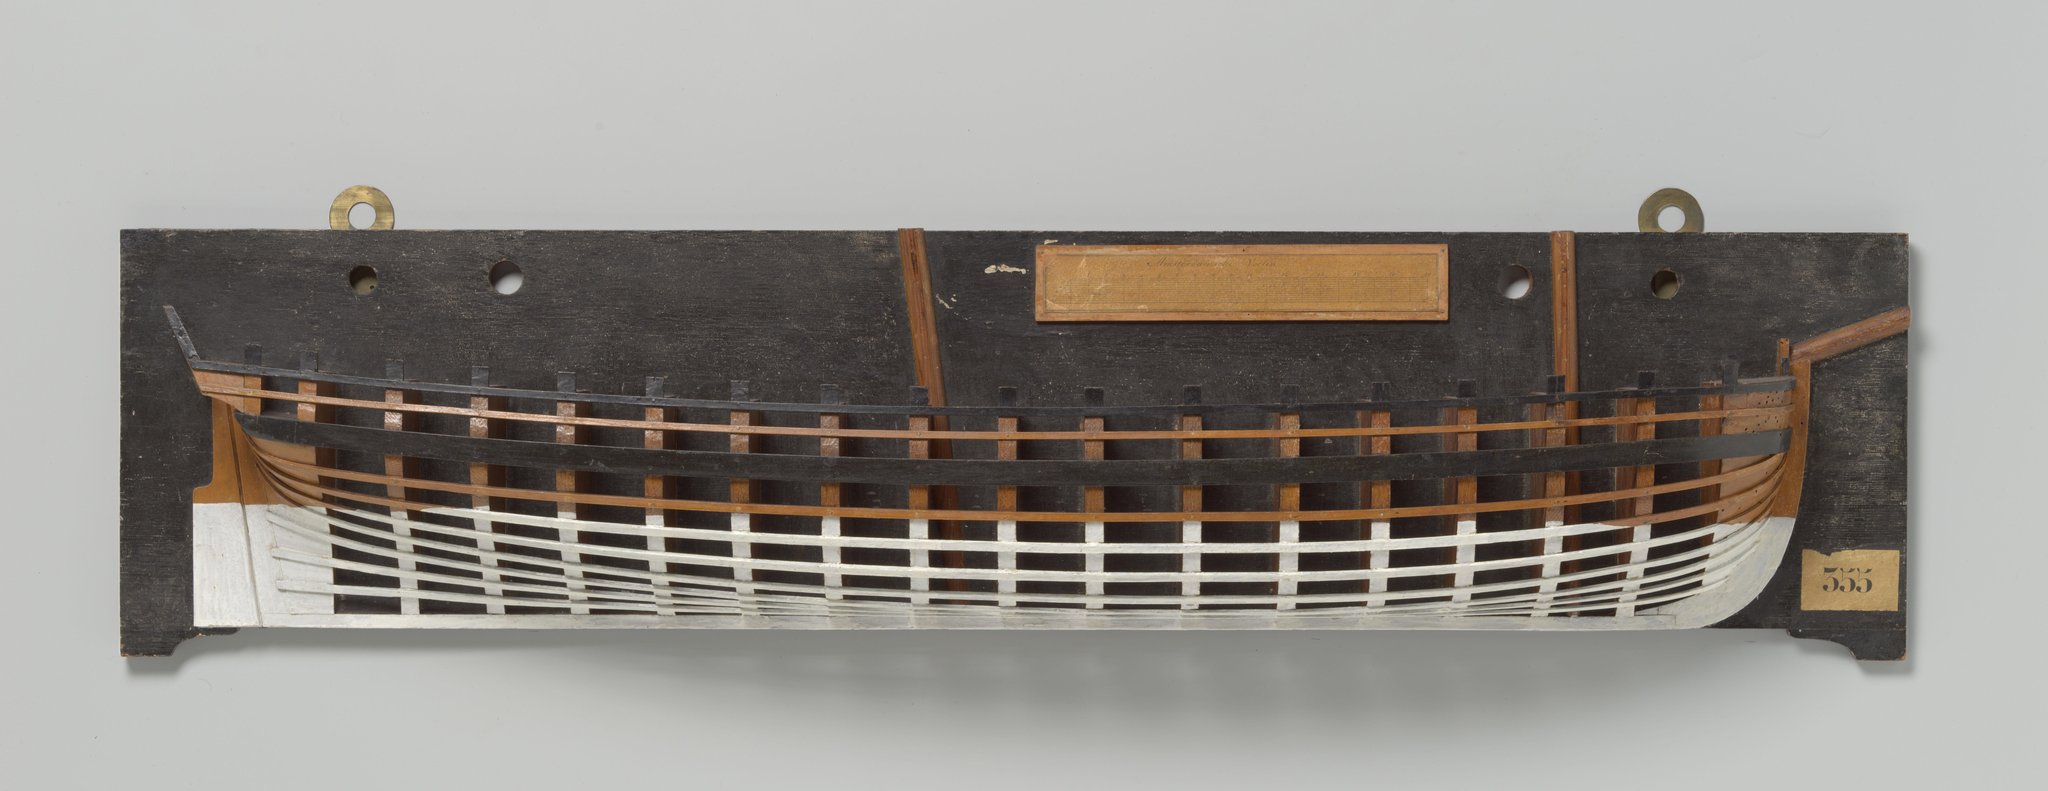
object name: ship model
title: Half Model of a 14-Gun Brig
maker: Anonymous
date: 1780-1820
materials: wood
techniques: polychromy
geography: amsterdam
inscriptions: label, bottom right: ‘355’ former inventory label, scale, top centre: paper scale in Amsterdam feet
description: Gepolychromeerd mallenmodel (stuurboord) van een tweemaster. Gewrongen spiegel, hol wulf, geen details van hek of zijgalerij; recht roer met vierkante roerkoning. Zeeg naar voor en achter iets oplopend, één barkhout. Iets gepiekt rondspant. Schaal 1:30 (schaal op model).